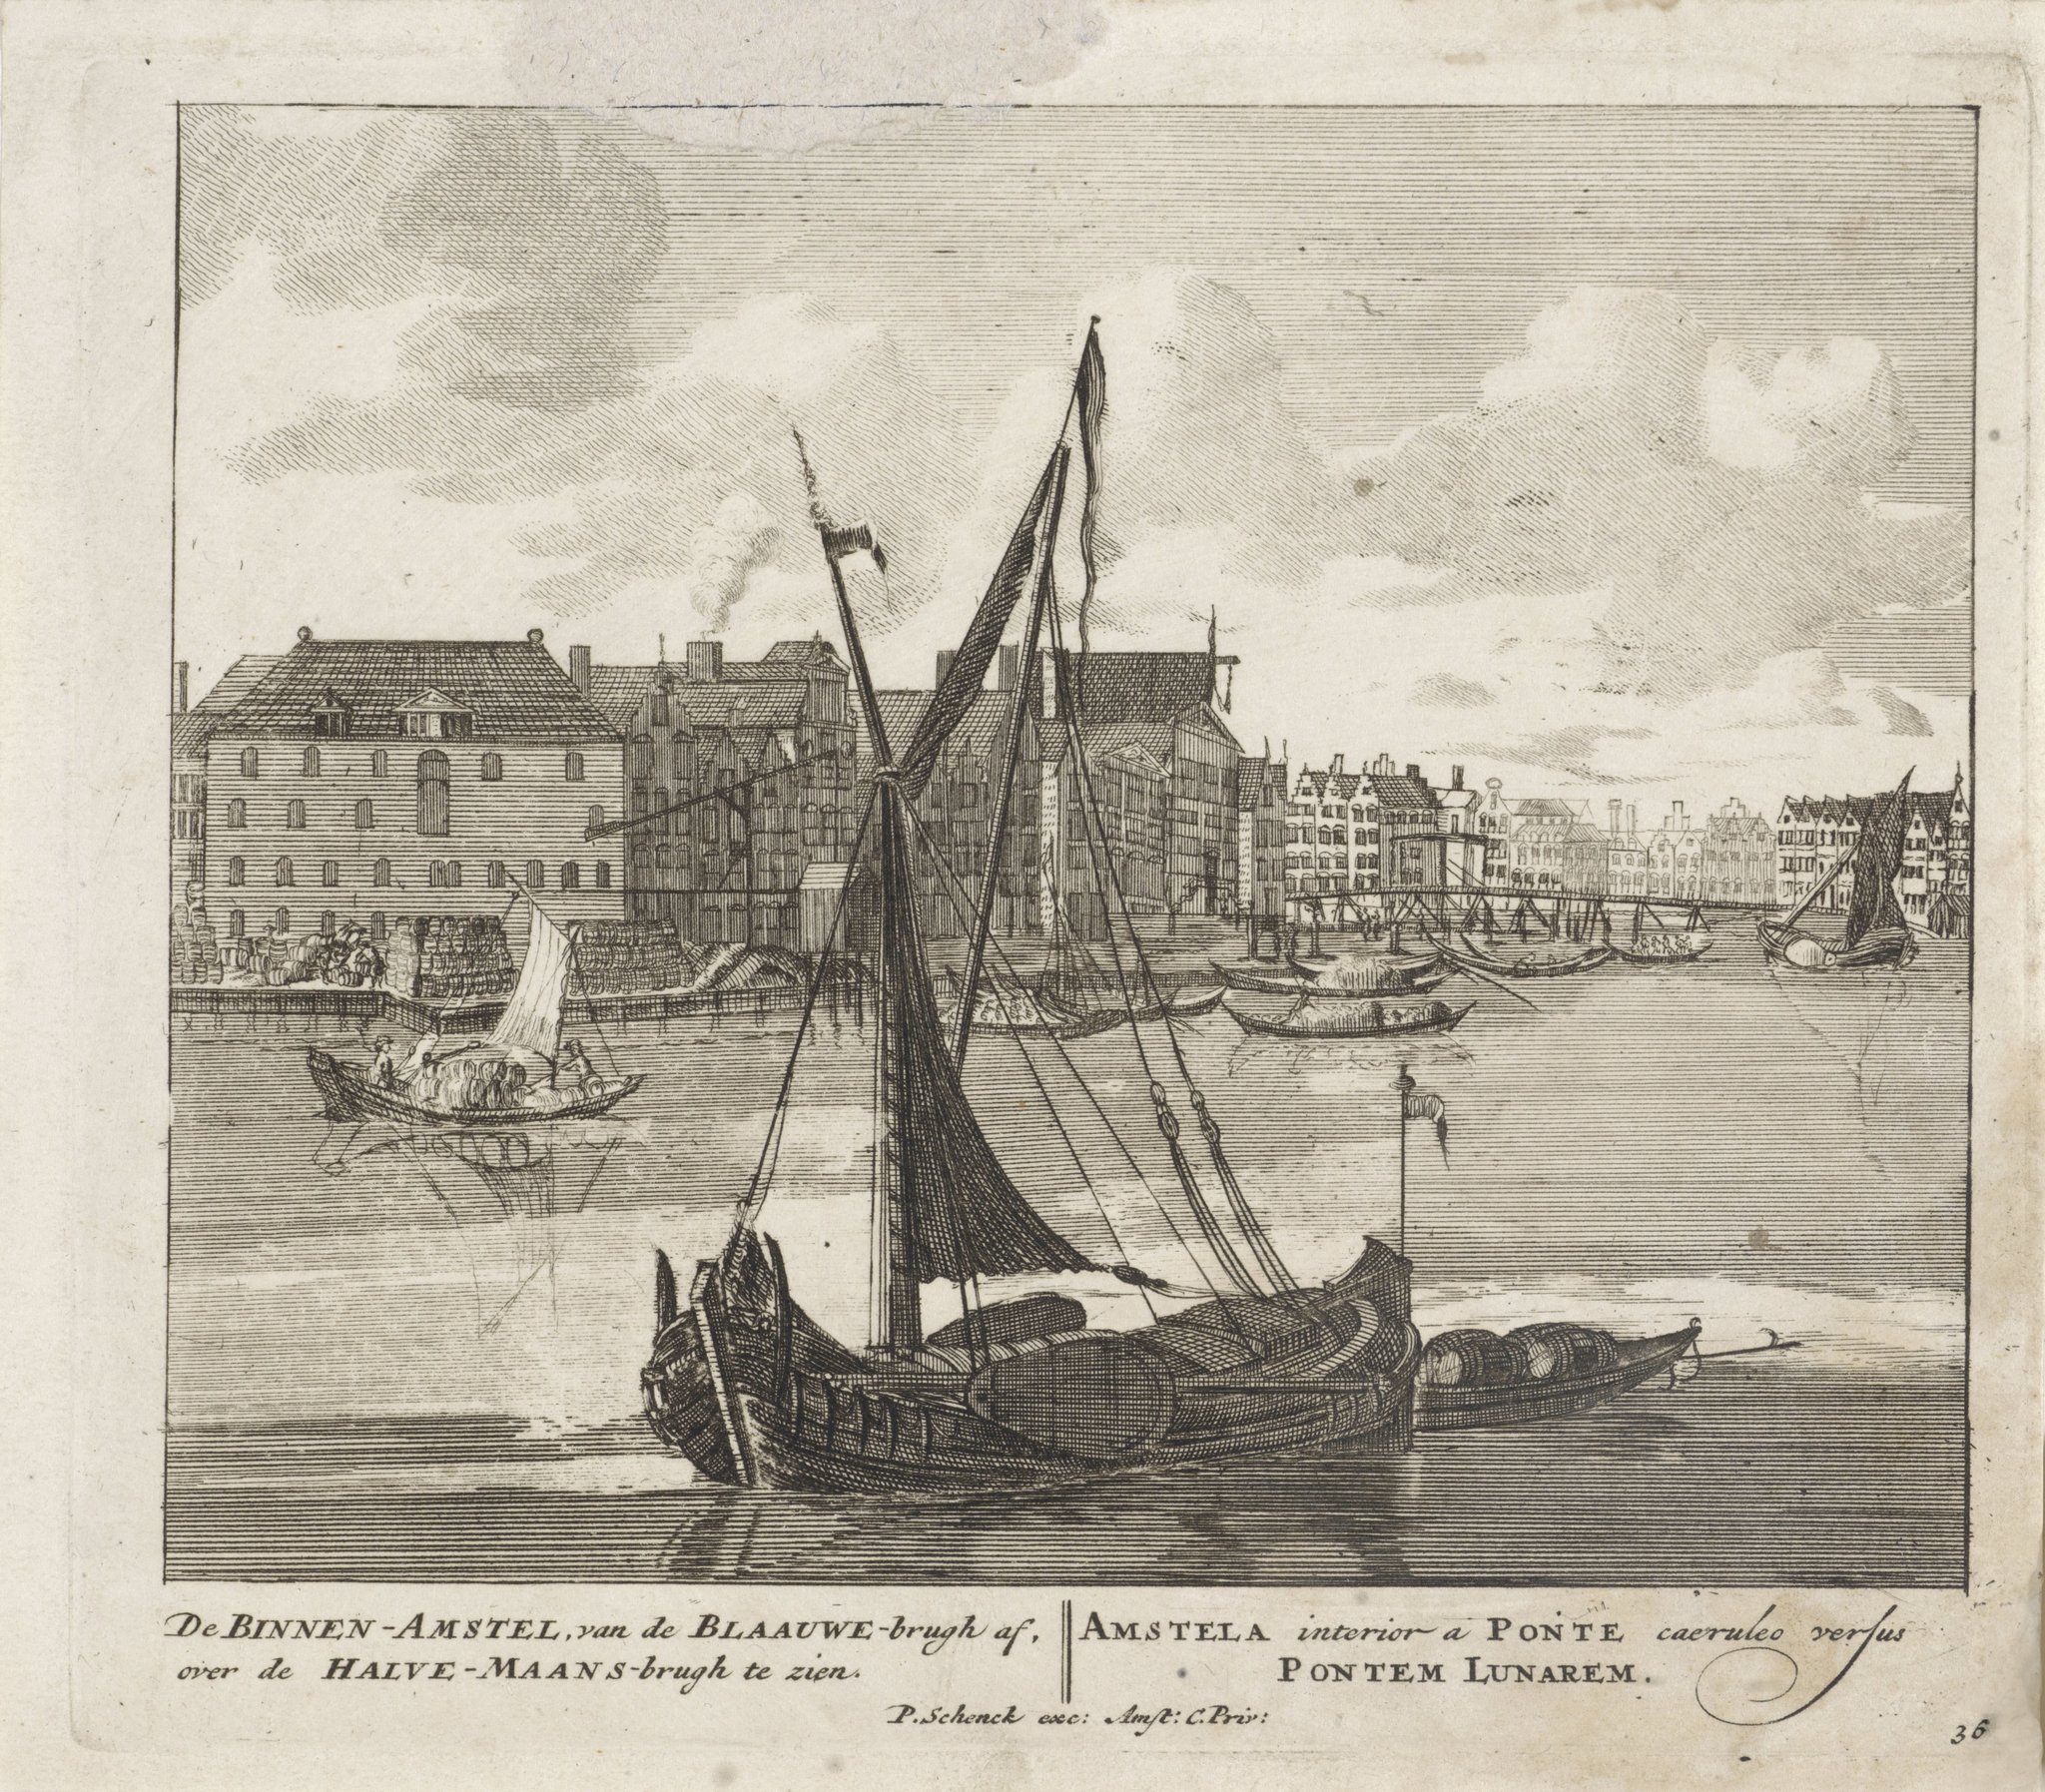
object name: print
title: Gezicht op de Binnen-Amstel en de Halvemaansbrug te Amsterdam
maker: Anonymous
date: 1710-1711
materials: paper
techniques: engraving, etching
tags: brewer, bridge in city across river, canal, etc. (+ city(-scape) with figures, staffage), canals, waters (in city) (+ city(-scape) with figures, staffage)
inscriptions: collector's mark: Lugt 2228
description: Huidige staat van prent ook gebruikt in: 100 Afbeeldinge der voornaamste gebouwen van Amsterdam. Amsterdam, Pieter Schenk (I), s.a. [1710-1711]. En in: 100 Afbeeldinge der voornaamste gebouwen van Amsterdam. Amsterdam, Barent Greve, s.a. [1757-1766].* *In de tweede uitgave, uitgegeven door Barent Greve, is alleen de titelprent aangepast. De overige prenten zijn onveranderd gebleven.